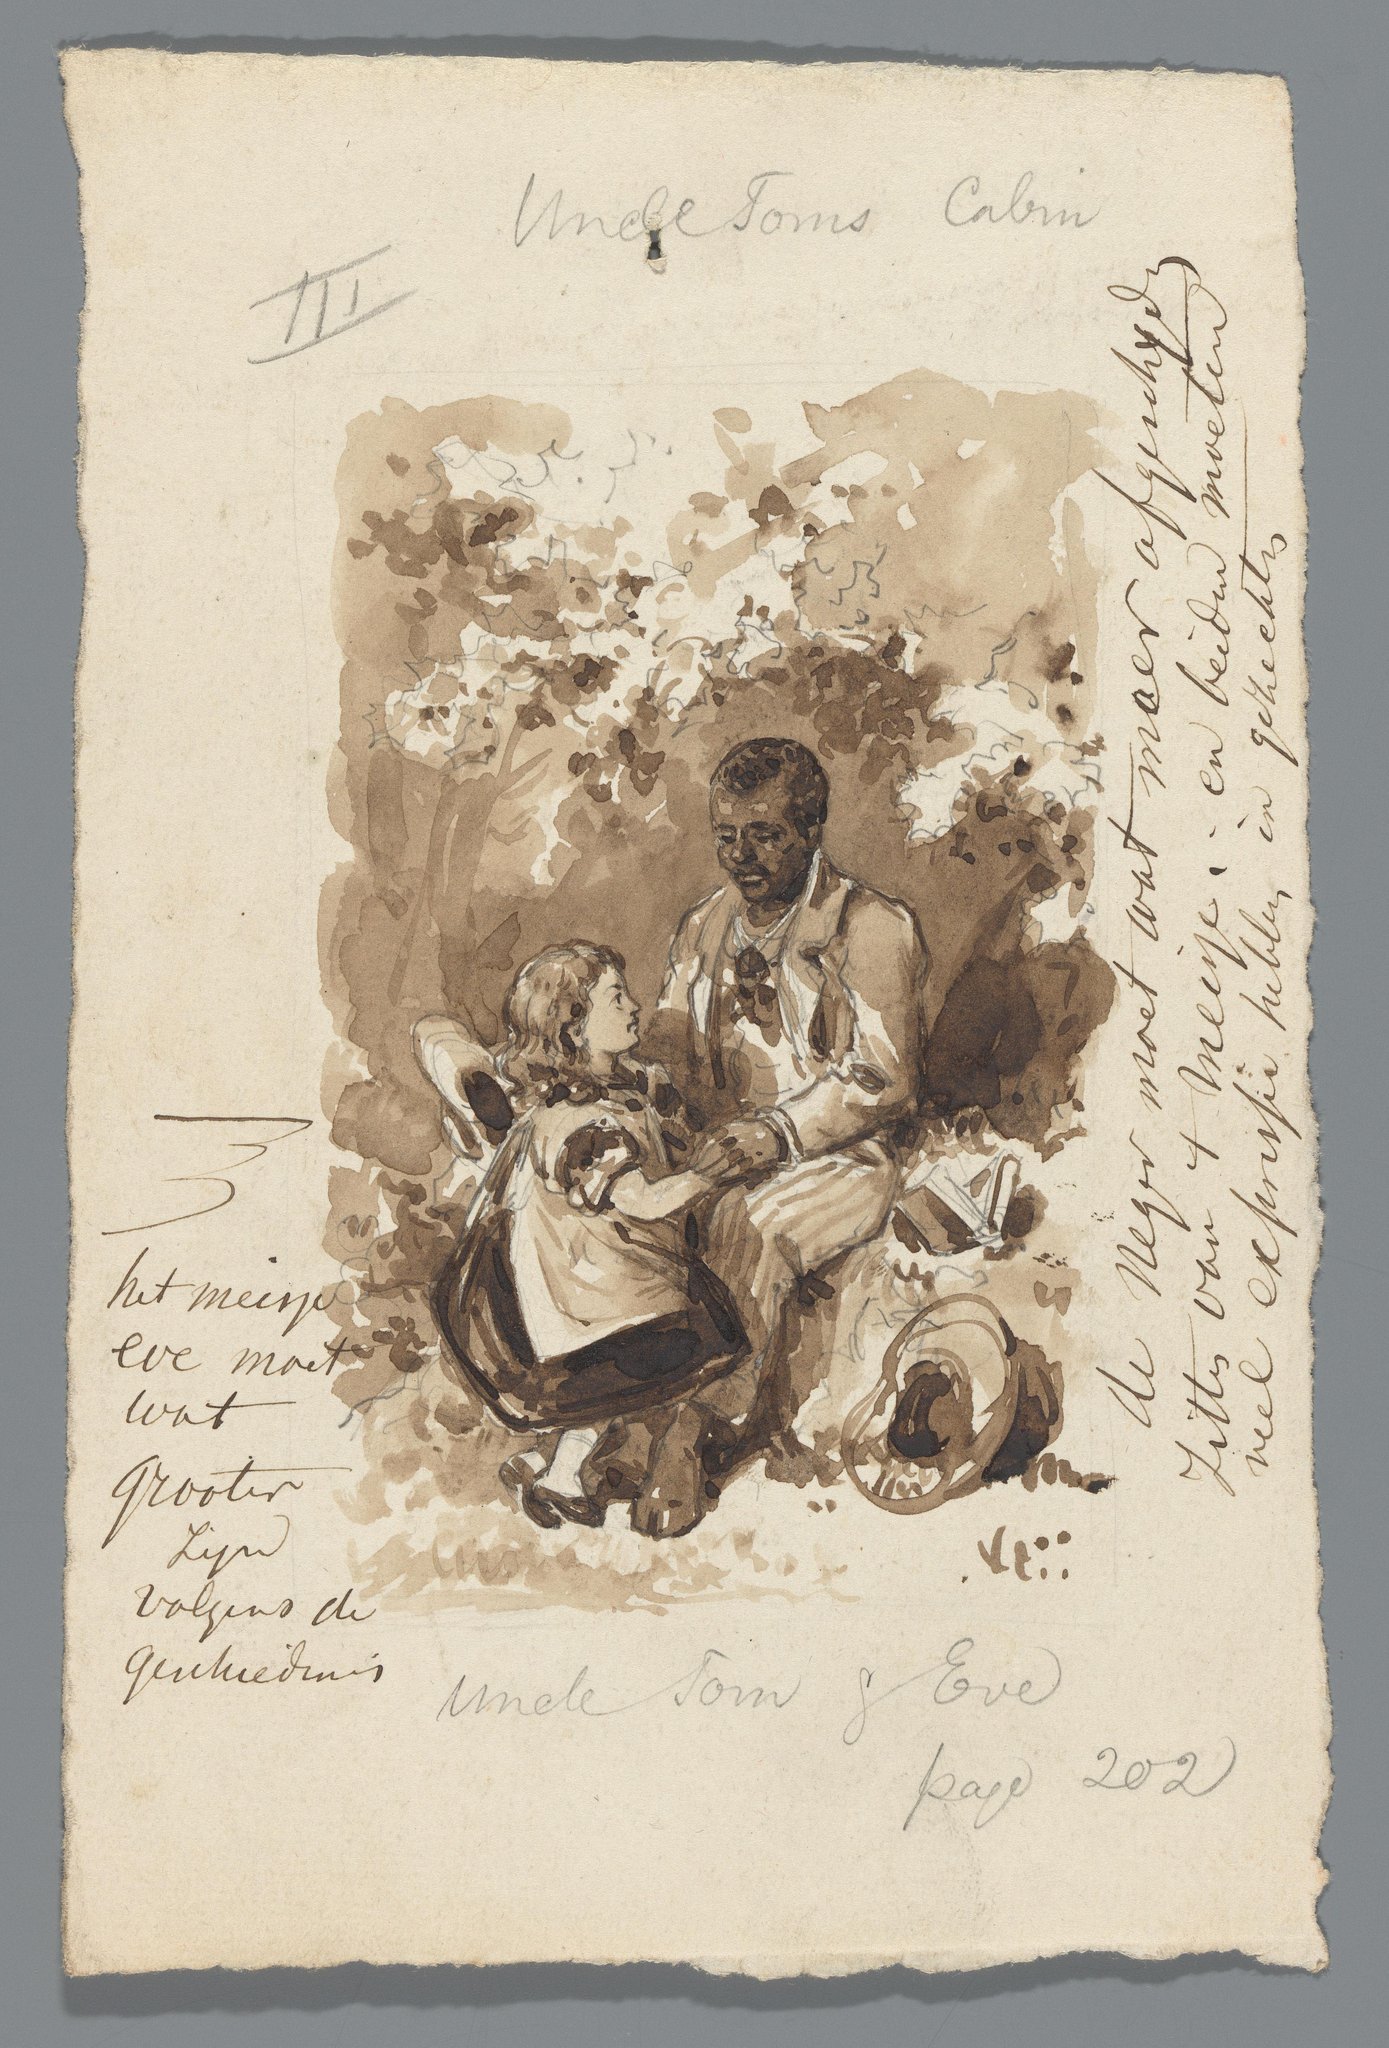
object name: design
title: Oom Tom en Eva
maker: joseph ludovic scheidel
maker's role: draughtsman, painter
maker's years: 1848-1895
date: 1852-1895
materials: paper, pencil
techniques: brush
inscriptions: annotation: ‘Engels citaat verwijzend naar de geïllustreerde passage en Nederlands commentaar van de uitgever op de tekening’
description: Ontwerp voor een boekillustratie in Harriët Beecher Stowe, "De Negerhut van Oom Tom".